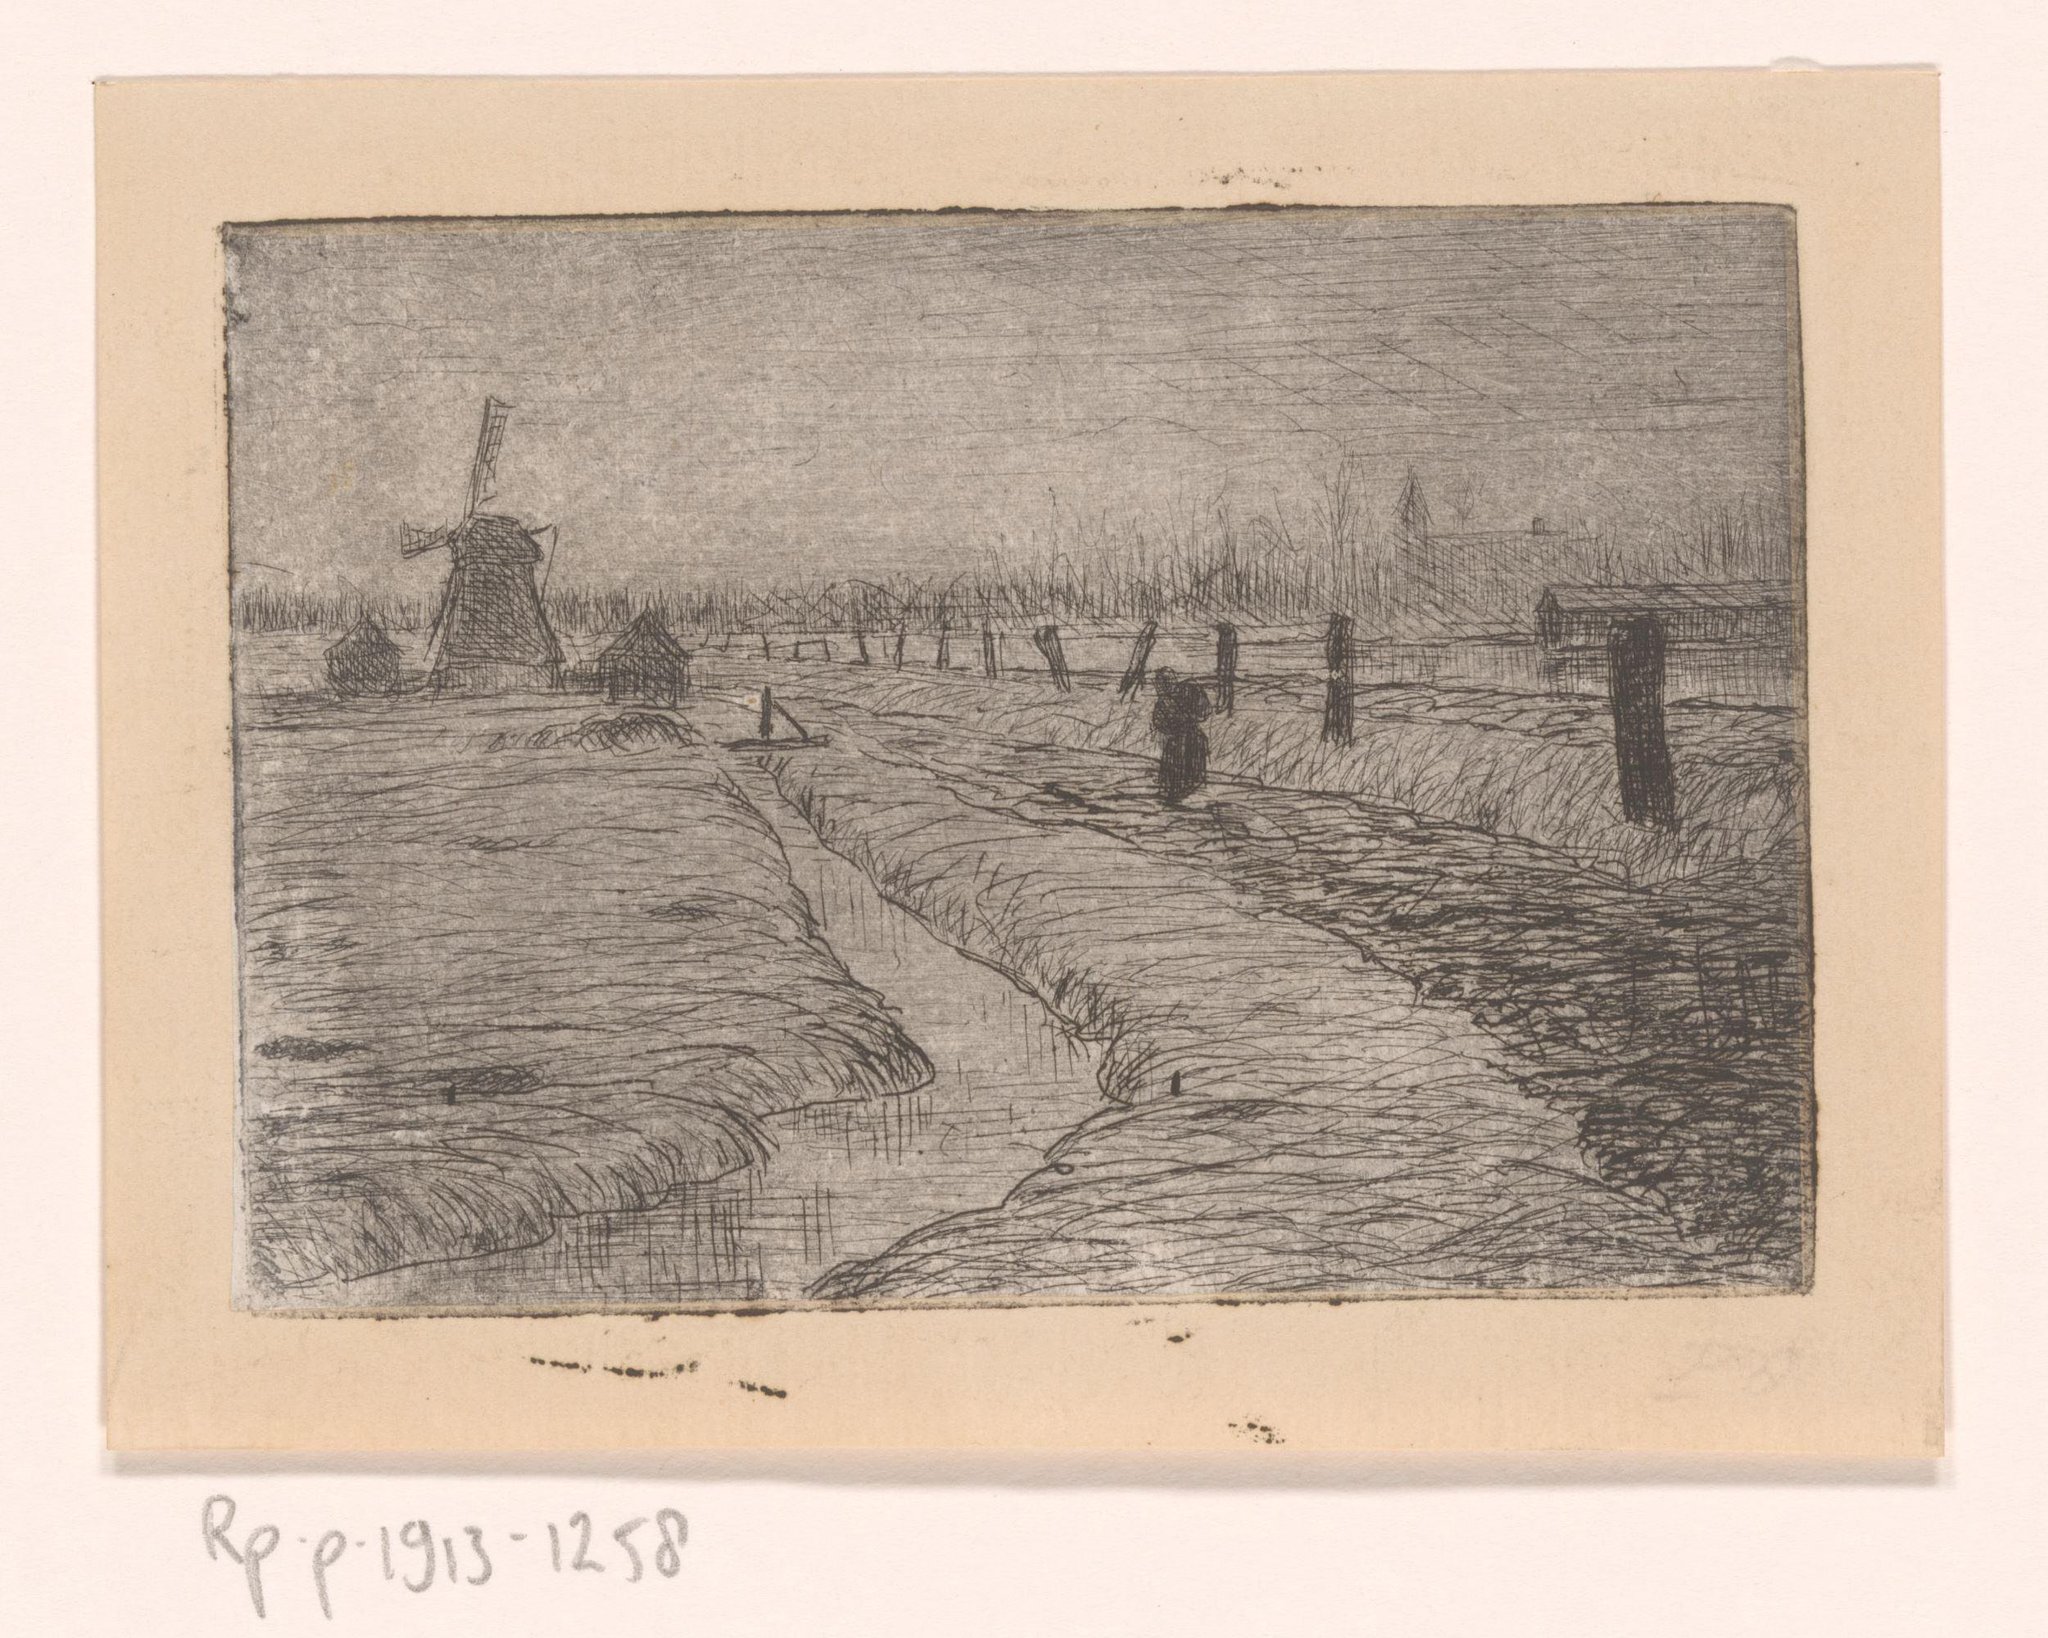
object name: print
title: Weidelandschap met molen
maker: philip zilcken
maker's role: draughtsman, painter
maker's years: 1857-1930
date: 1867-1890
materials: paper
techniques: drypoint, etching, intaglio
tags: windmill in landscape - ii - ideal landscapes, small canal, ditch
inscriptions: collector's mark: Lugt 2233